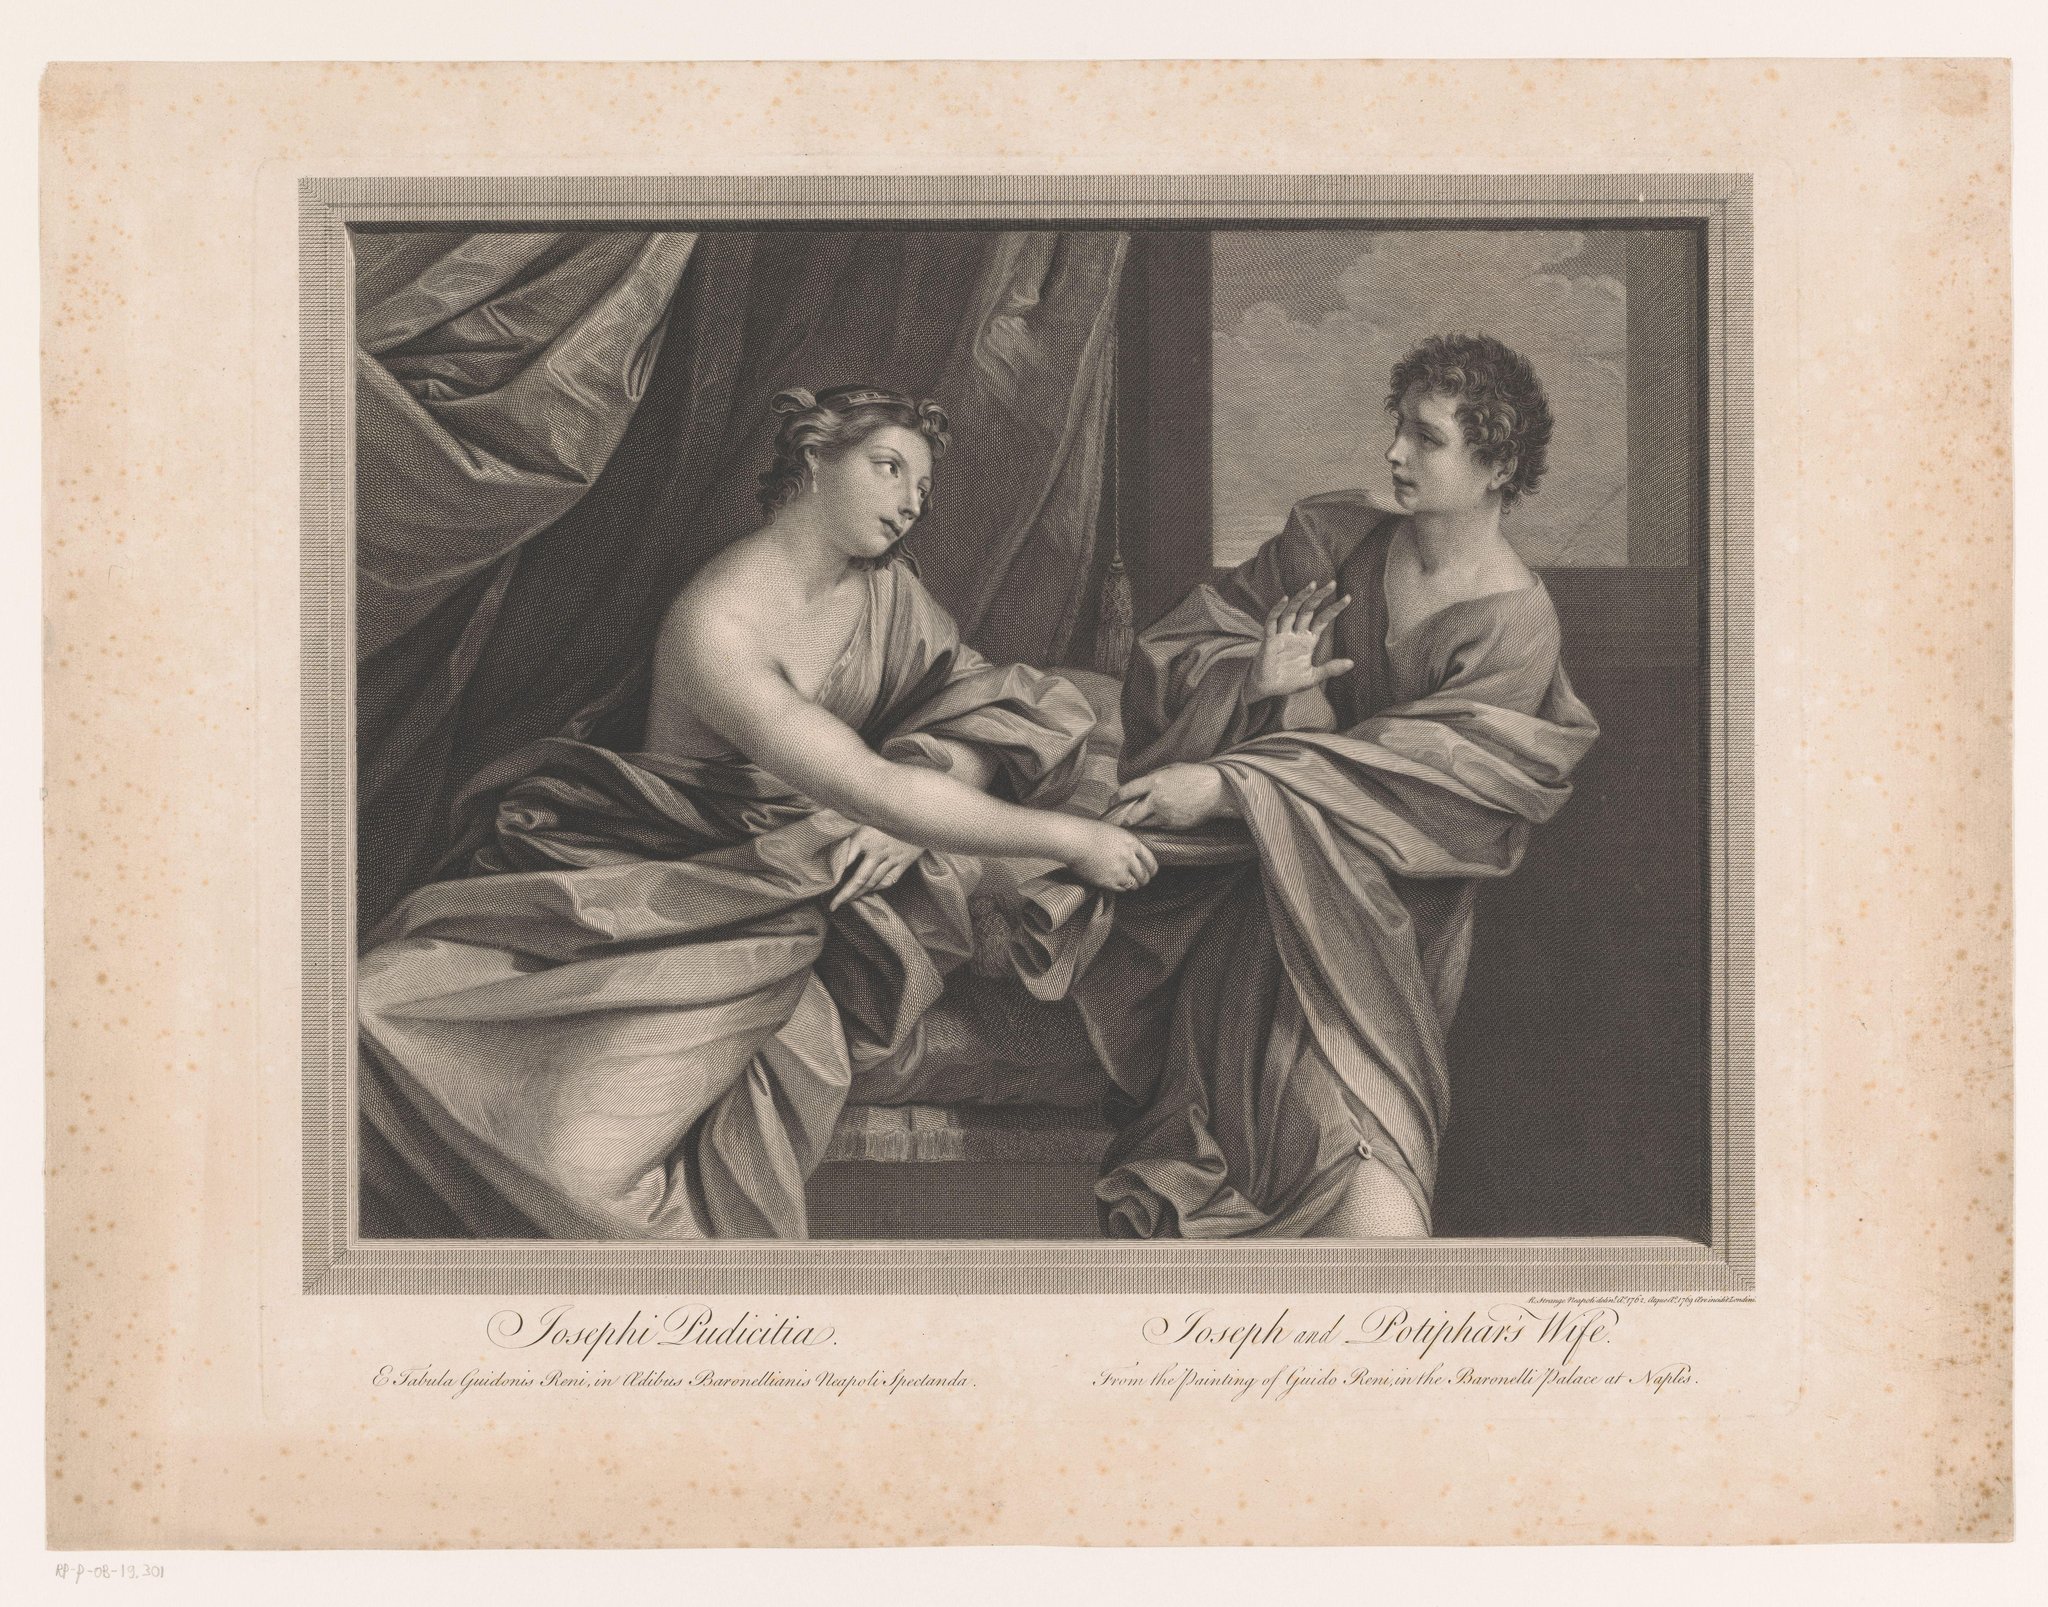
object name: print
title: Josephi Pudicitia / Joseph and Potiphar's Wife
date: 1762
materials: paper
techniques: engraving, etching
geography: naples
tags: potiphar's wife trying to seduce joseph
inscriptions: collector's mark: Lugt 240